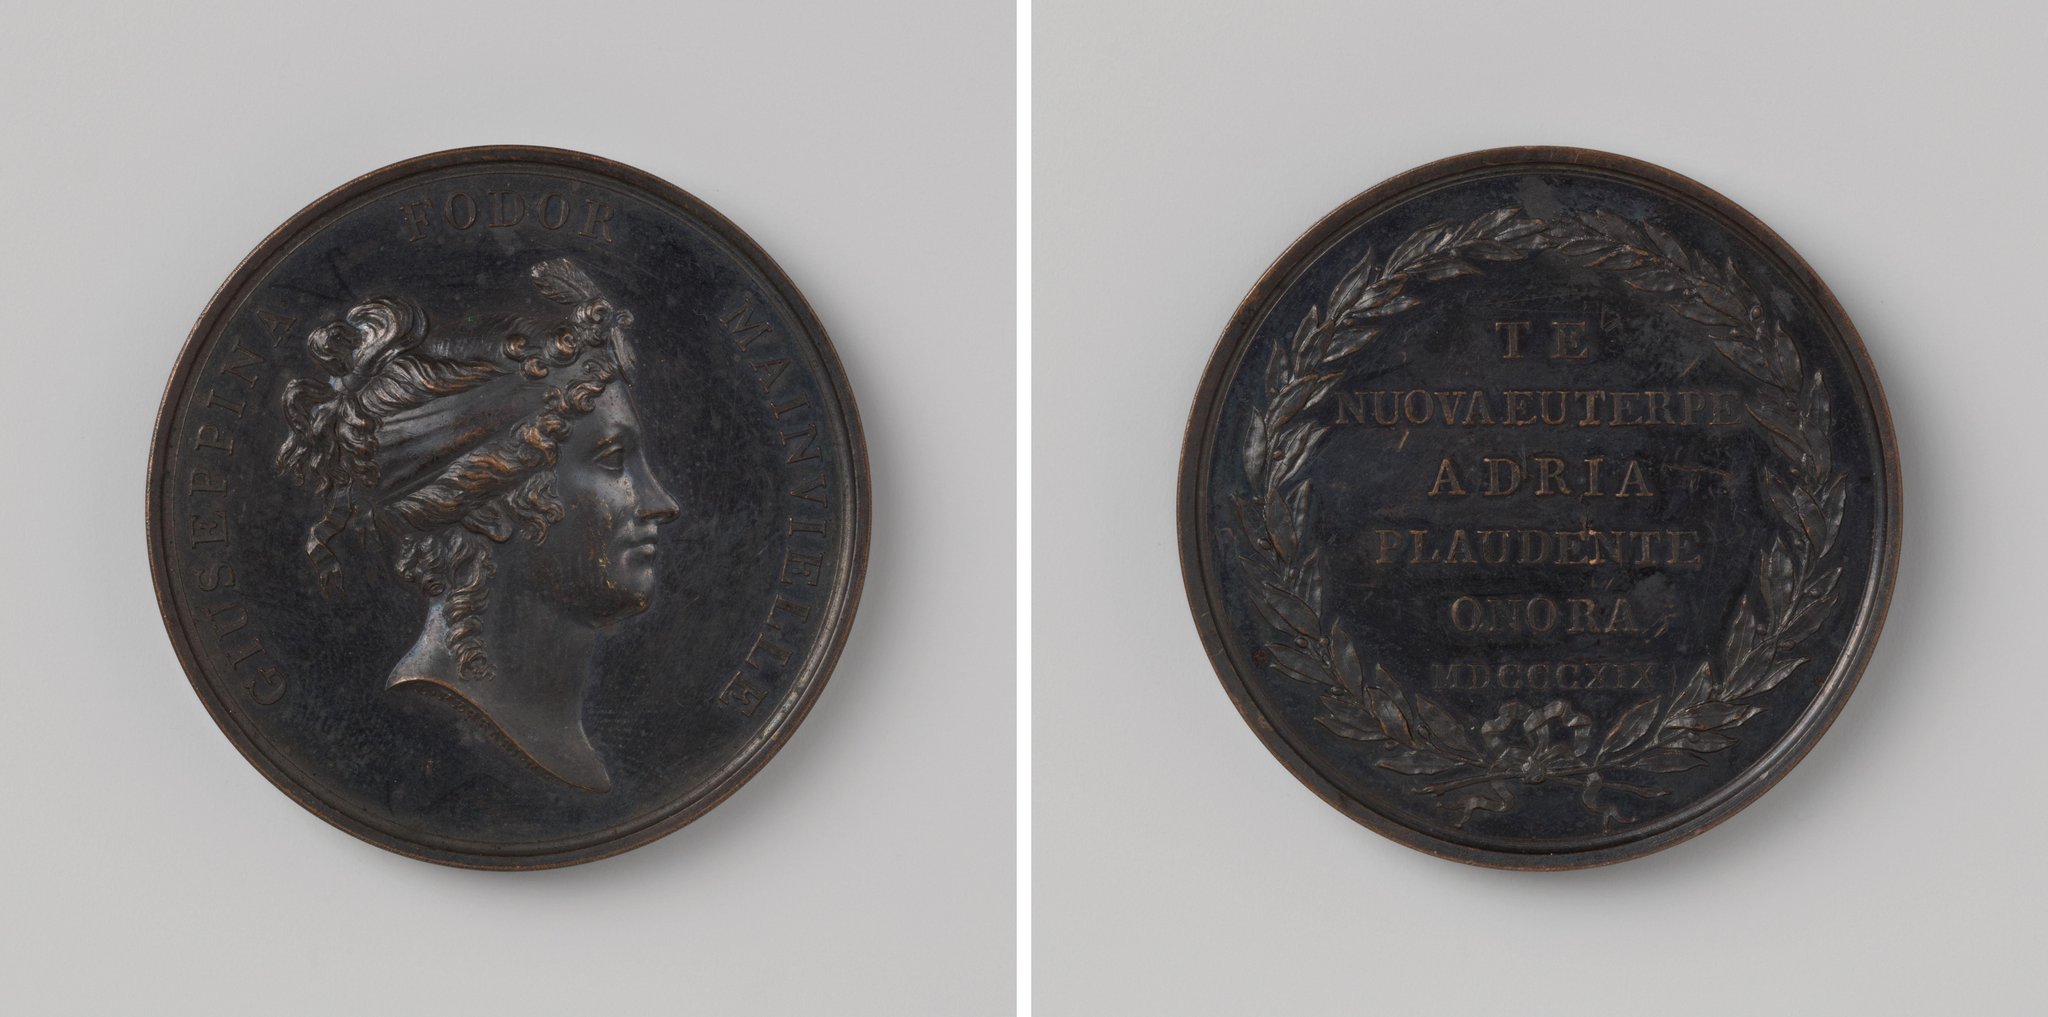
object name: history medal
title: Josephine Fodor Mainvielle, zangeres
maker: luigi ferrari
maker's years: 1804-1844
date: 1819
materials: bronze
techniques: striking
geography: venice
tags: josephine fodor mainvielle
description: Bronzen penning. Voorzijde: borststuk vrouw binnen omschrift. Keerzijde: opschrift binnen lauwerkrans